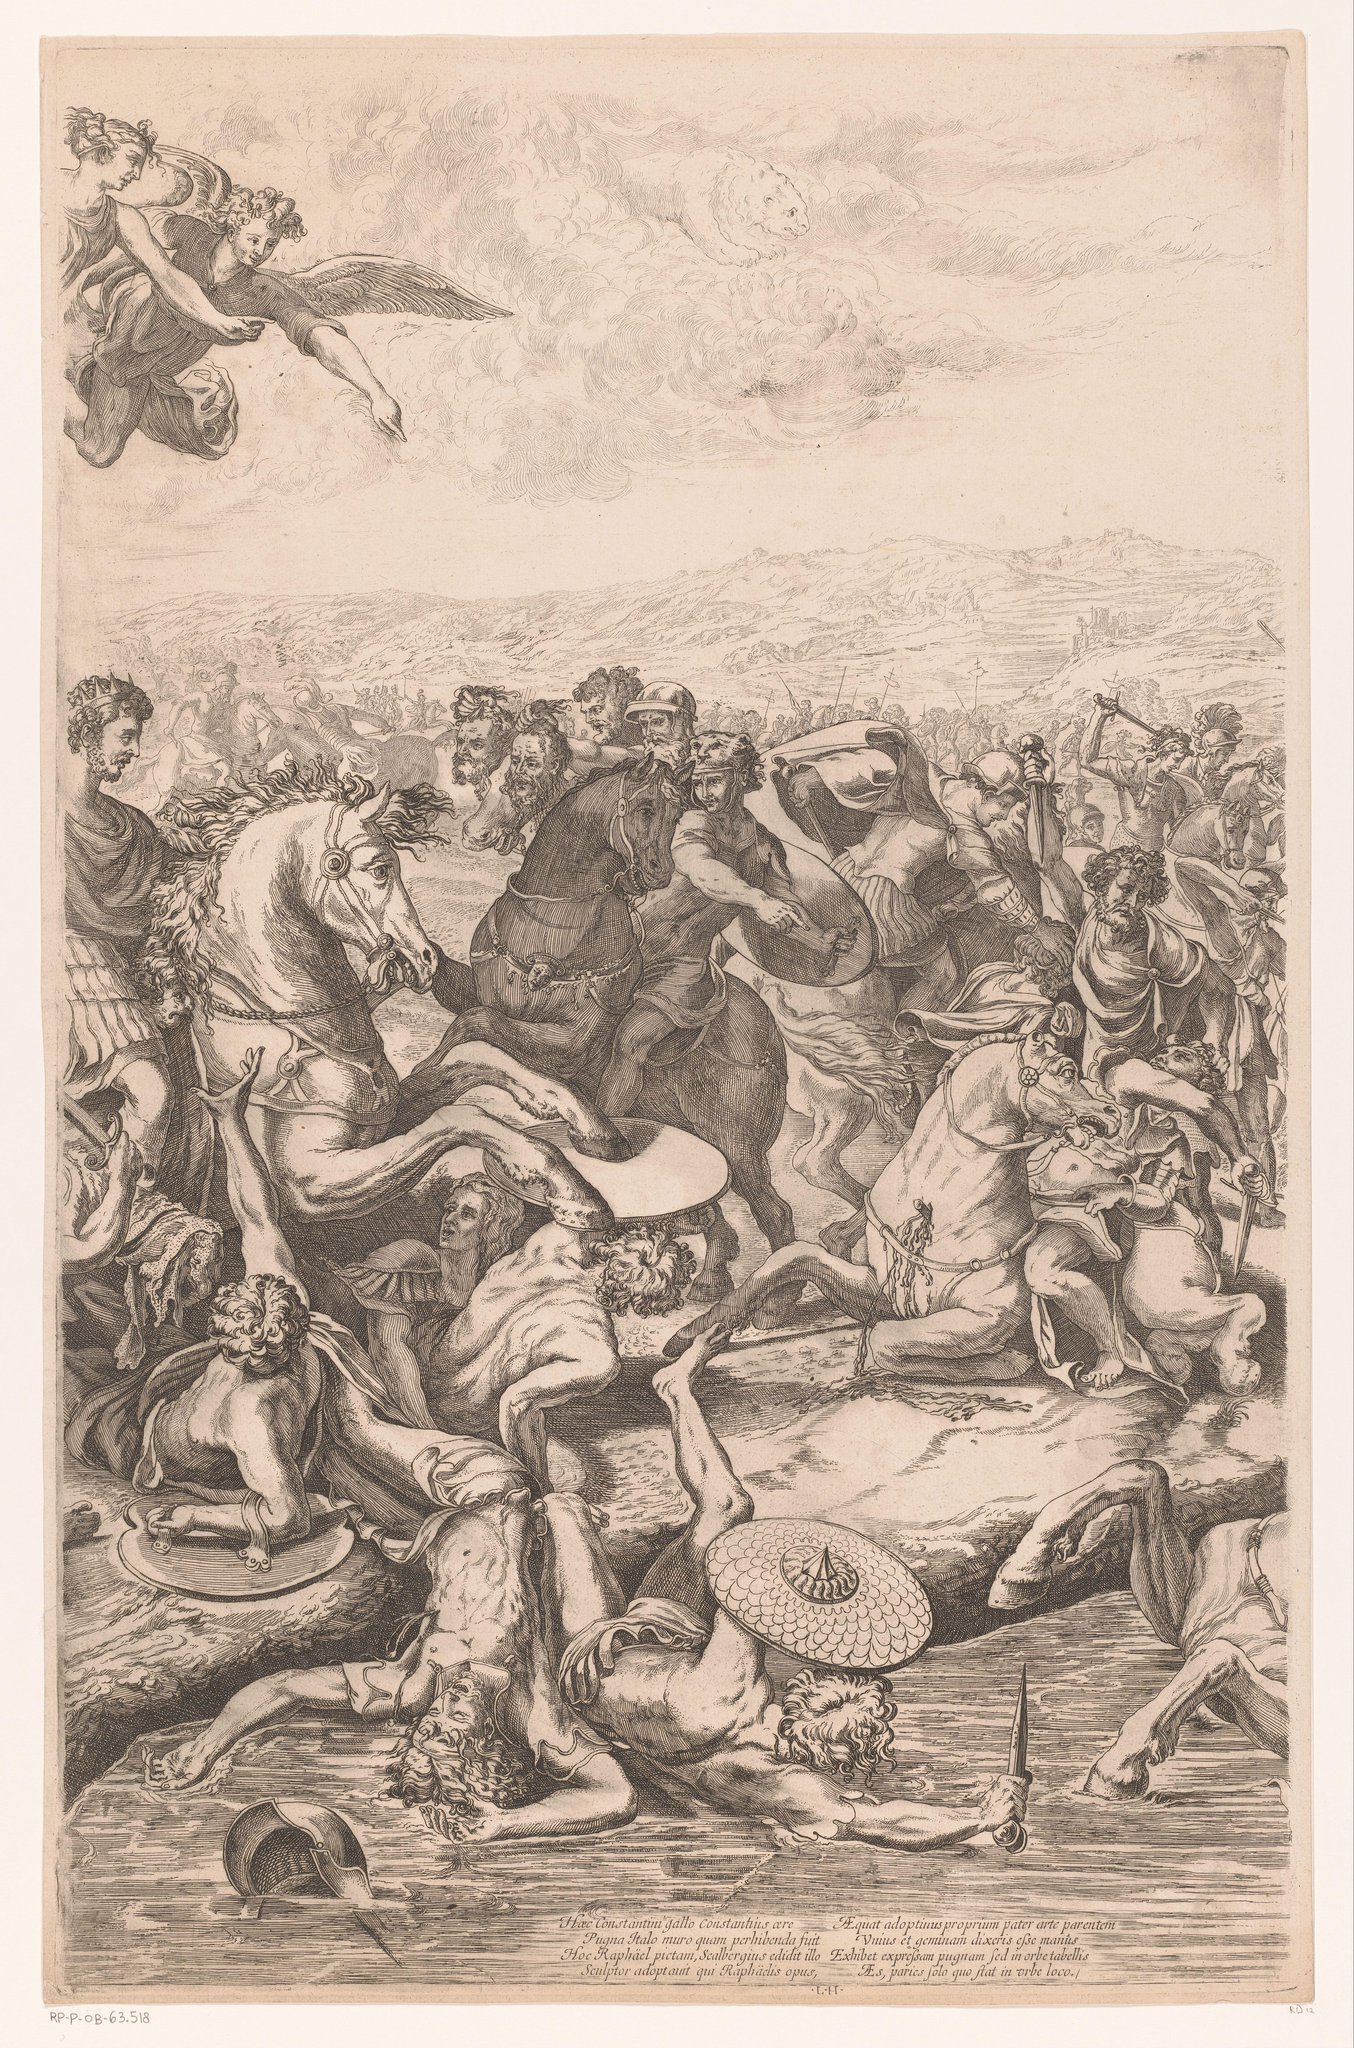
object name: print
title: Slag bij de Milvische brug (derde deel)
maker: pierre scalberge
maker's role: print maker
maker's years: 1592-1640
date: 1637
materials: paper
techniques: etching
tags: the battle of the milvian bridge (saxa rubra): st. constantine on horseback confronts maxentius; a cross appears in the sky with in fiery letters 'in hoc signo vinces' (the raised standards of the roman soldiers carry a cross or the chi-rho monogram)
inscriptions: collector's mark: Lugt 240